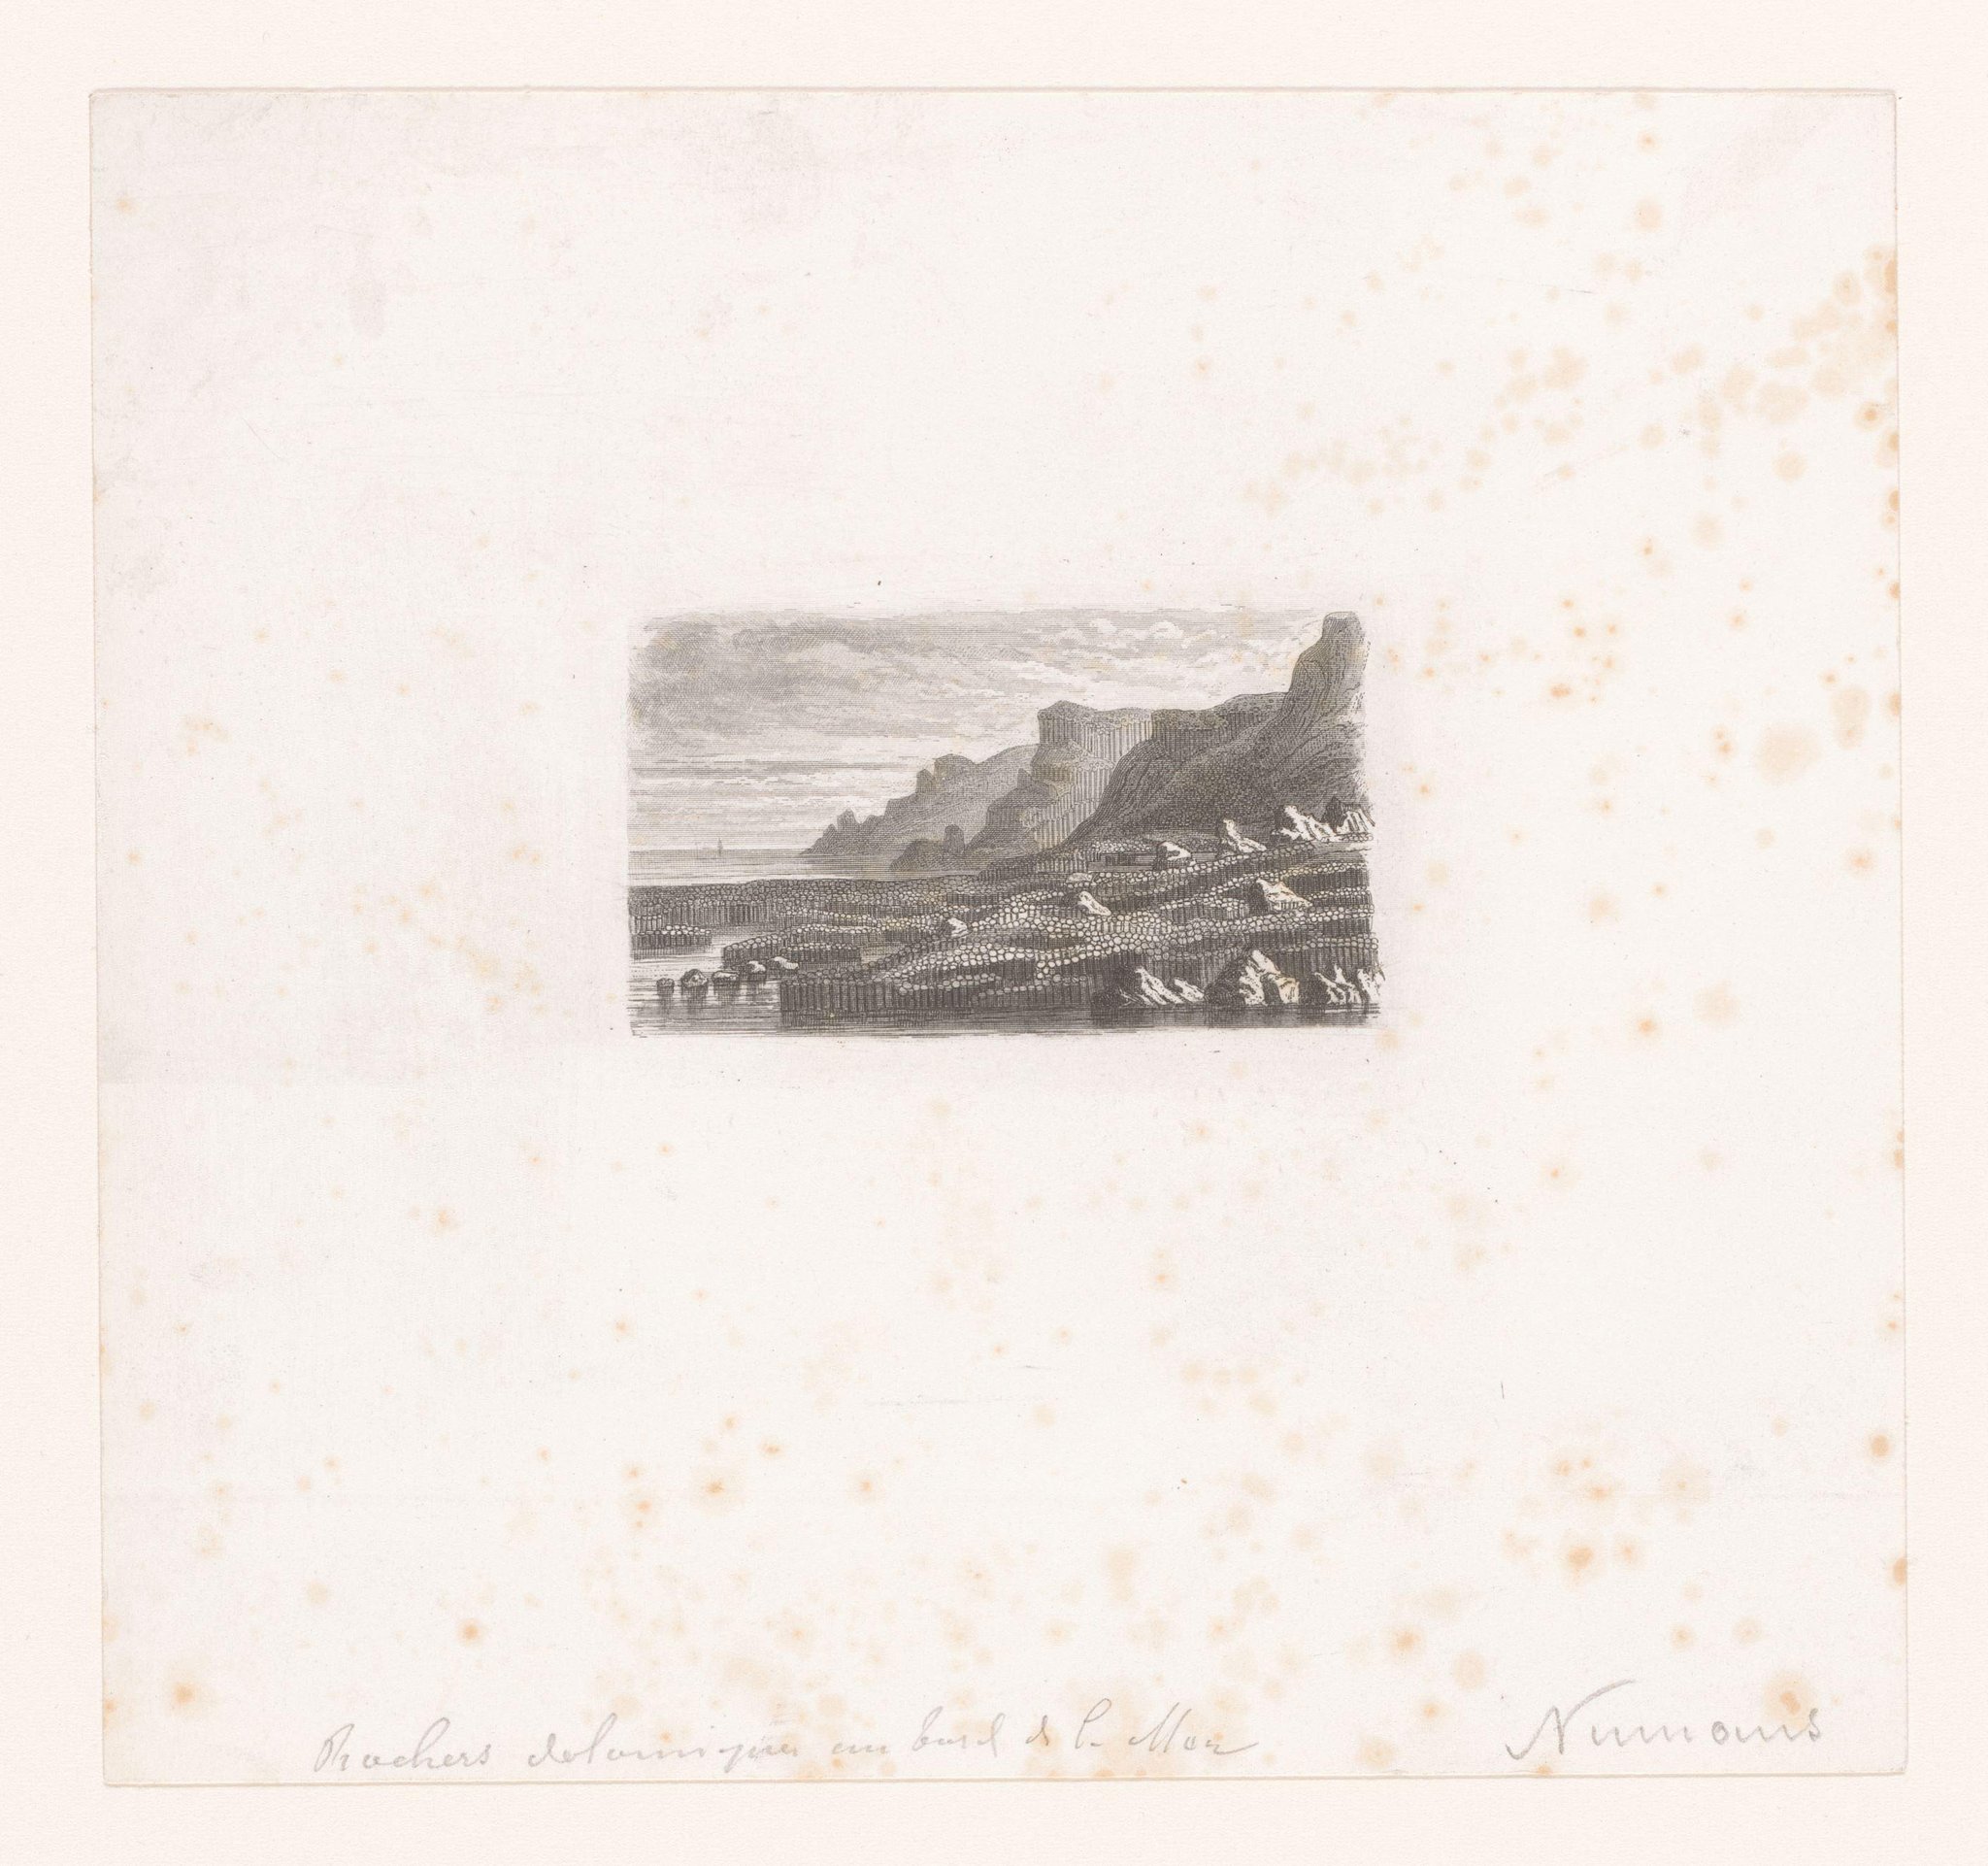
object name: print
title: Dolomieten aan zee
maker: auguste numans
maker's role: print maker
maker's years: 1823-1883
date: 1833-1879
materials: paper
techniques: engraving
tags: rocky coast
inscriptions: collector's mark: Lugt 2228